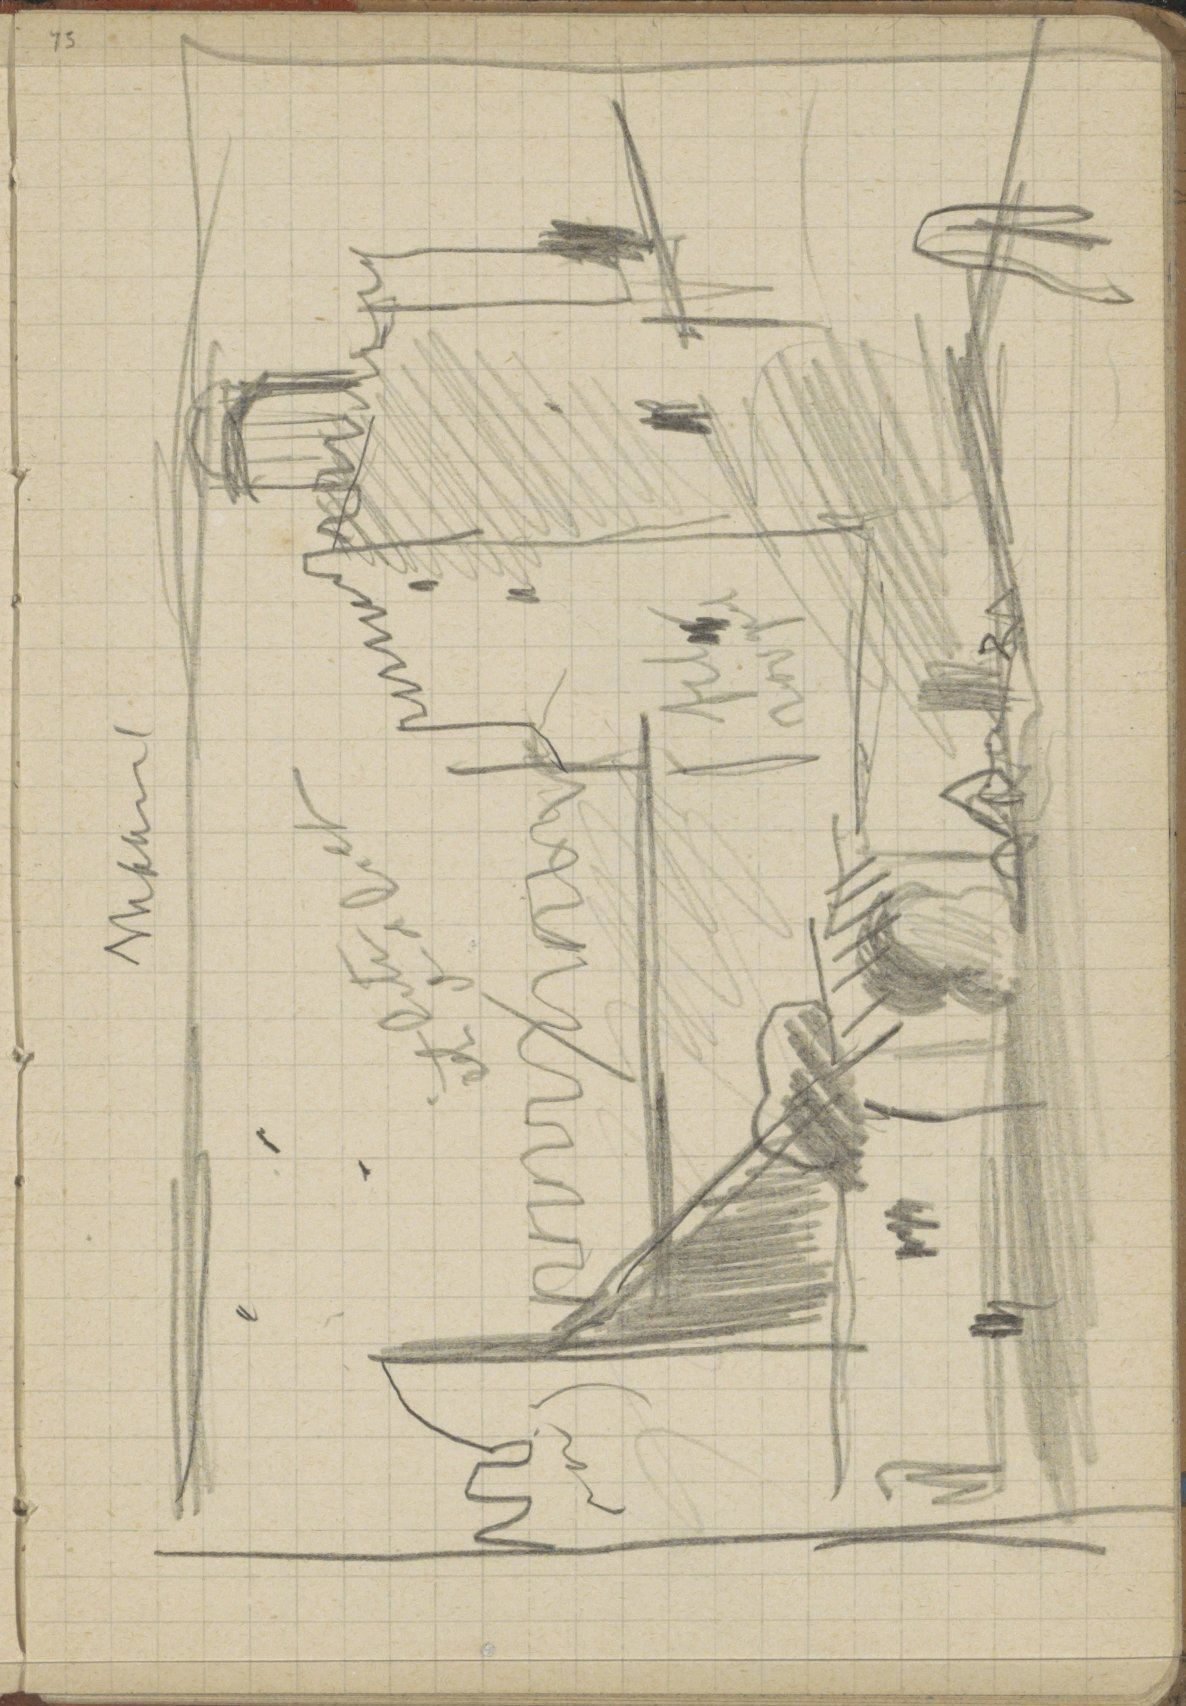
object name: sketchbook leaf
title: Gebouw en toren met kantelen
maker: marius bauer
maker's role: draughtsman, print maker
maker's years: 1867-1932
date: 1909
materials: pencil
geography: tunisia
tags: towers ~ fortified city, battlement, crenellation ~ fortified city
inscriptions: annotation: ‘maanl’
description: Mogelijk een moskee. Pagina 73 uit een schetsboek met 67 bladen.